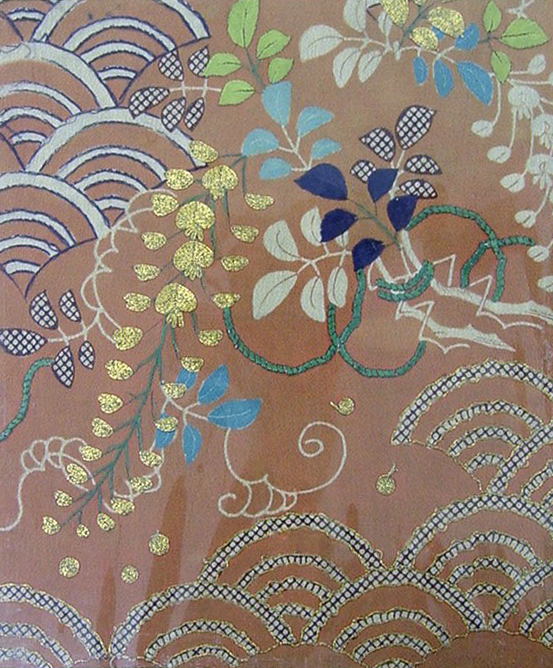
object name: piece from a kosode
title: Piece from a Kosode with Wisteria and Stylized Waves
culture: japanese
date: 1615-1868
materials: metal thread, silk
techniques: dyeing, embroidery, painting, weave, resist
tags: leaves